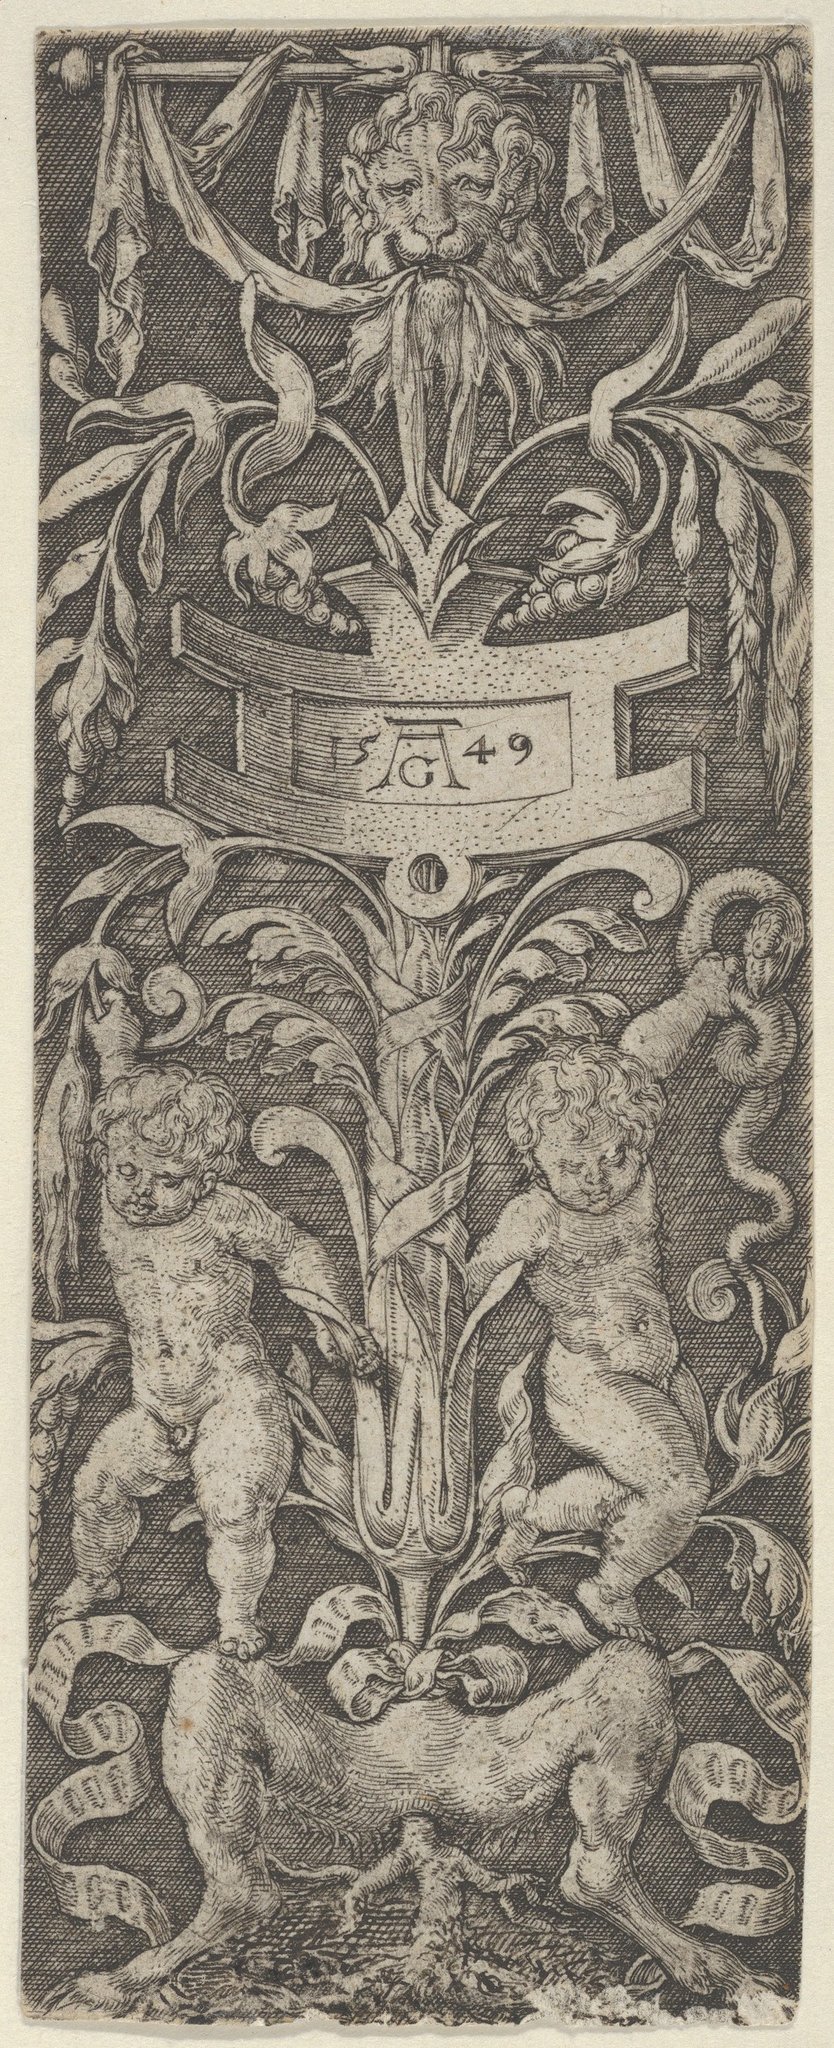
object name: print ornament architecture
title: Panel of Ornament with Two Nude Boys Standing on the Legs of a Satyr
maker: heinrich aldegrever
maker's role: artist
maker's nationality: german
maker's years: 1502-1561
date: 1549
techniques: engraving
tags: boys,satyrs,plants